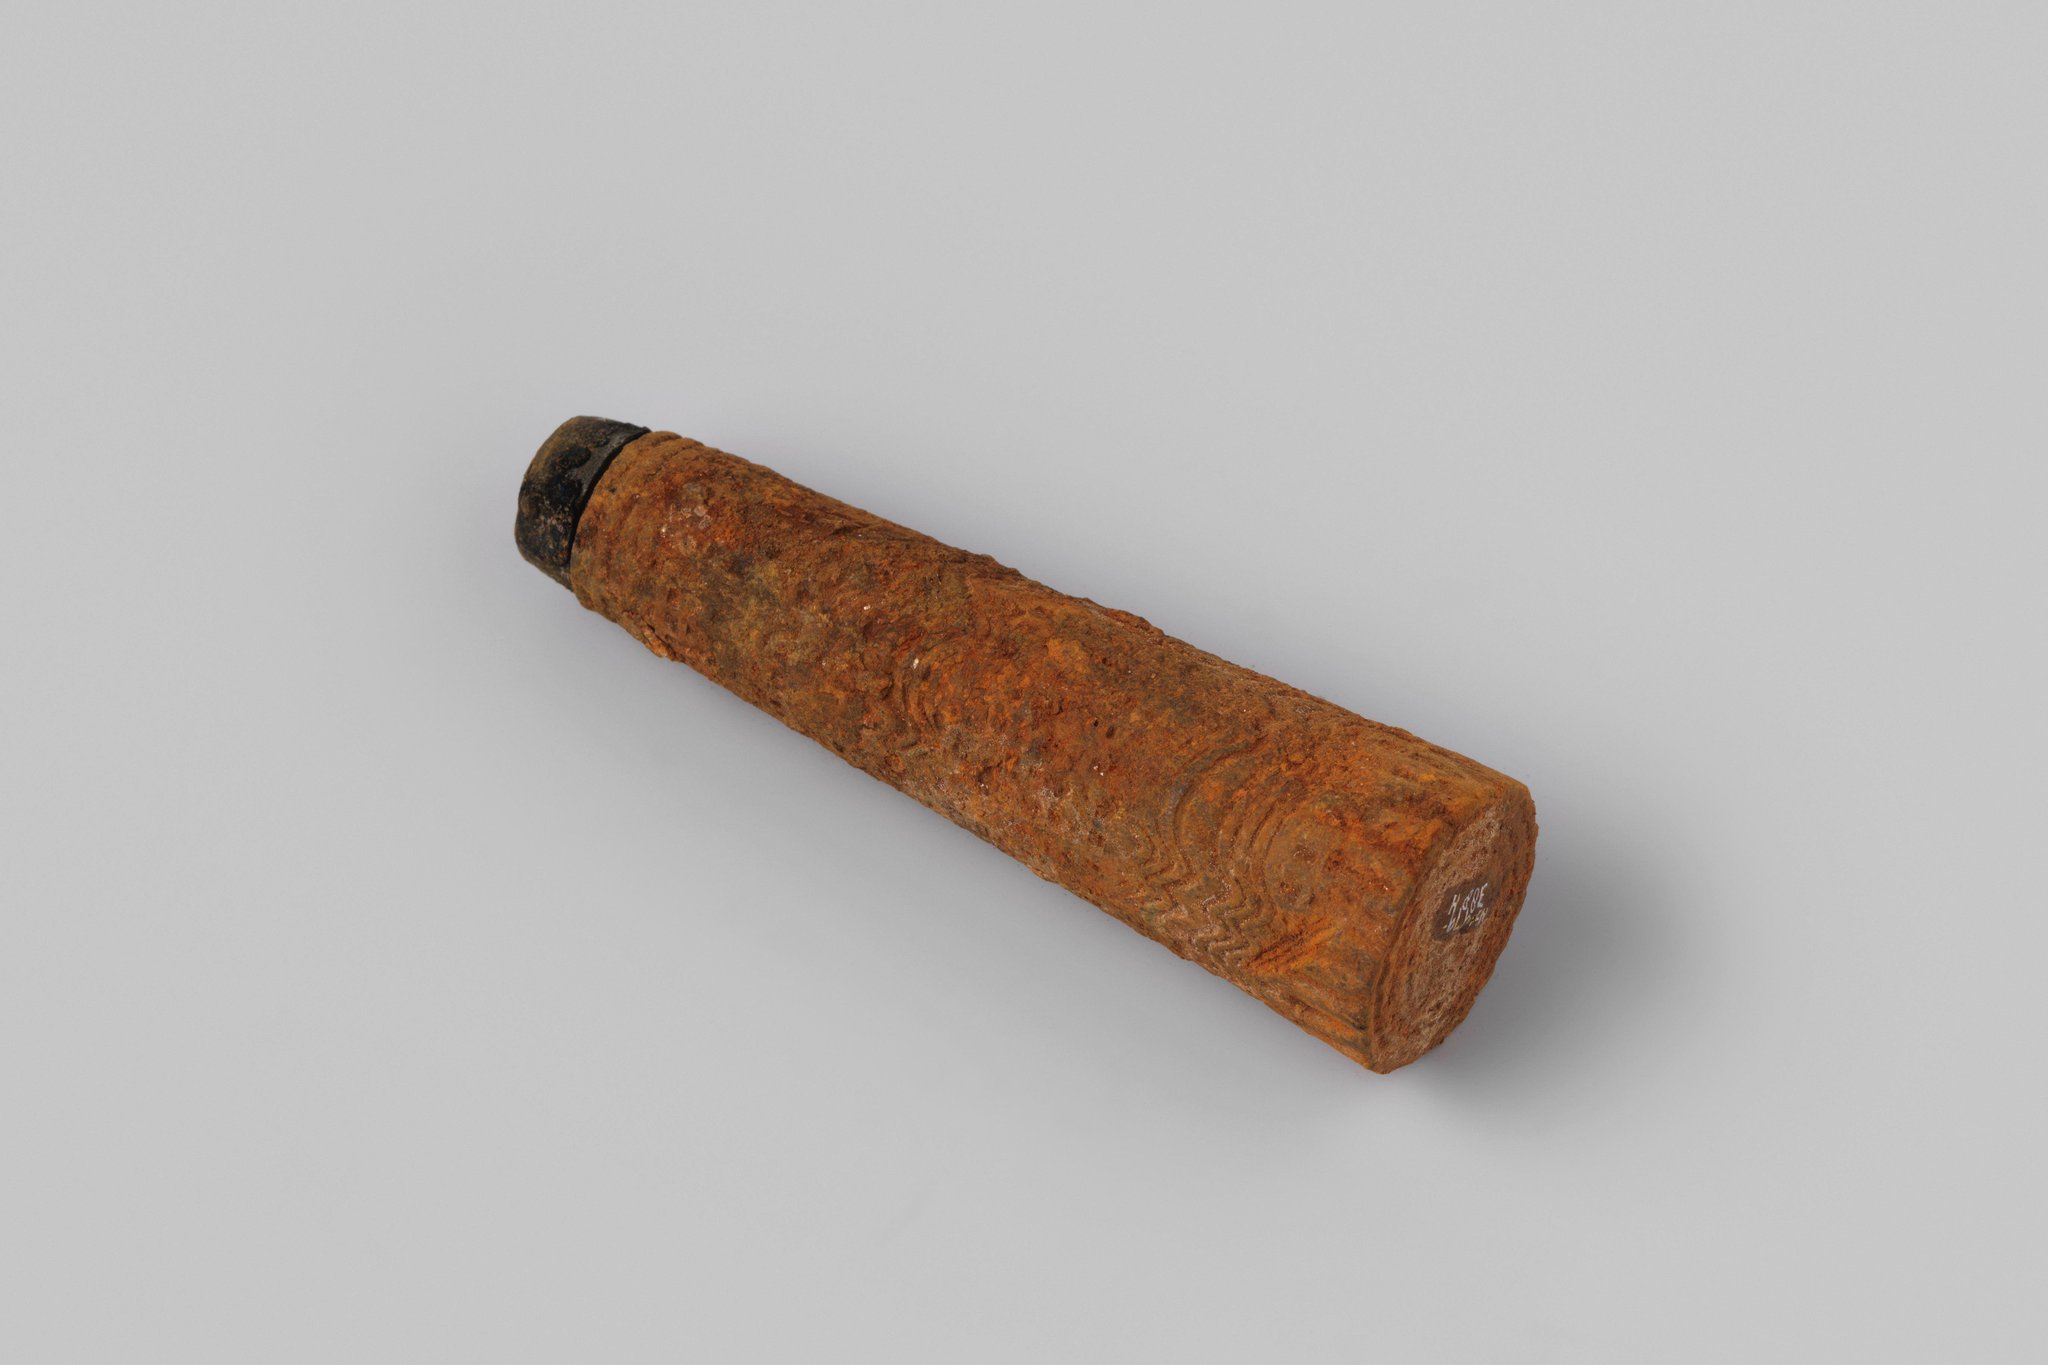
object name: knife handle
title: Messenheft uit het wrak van de Oost-Indiëvaarder Hollandia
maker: Anonymous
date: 1700-1743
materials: copper, wood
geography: netherlands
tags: verenigde oostindische compagnie, hollandia (schip), annet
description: Knife, handle, cylindrical: tapering; id. NG 1979-403H, ferrules id. NG 1980-27H426.